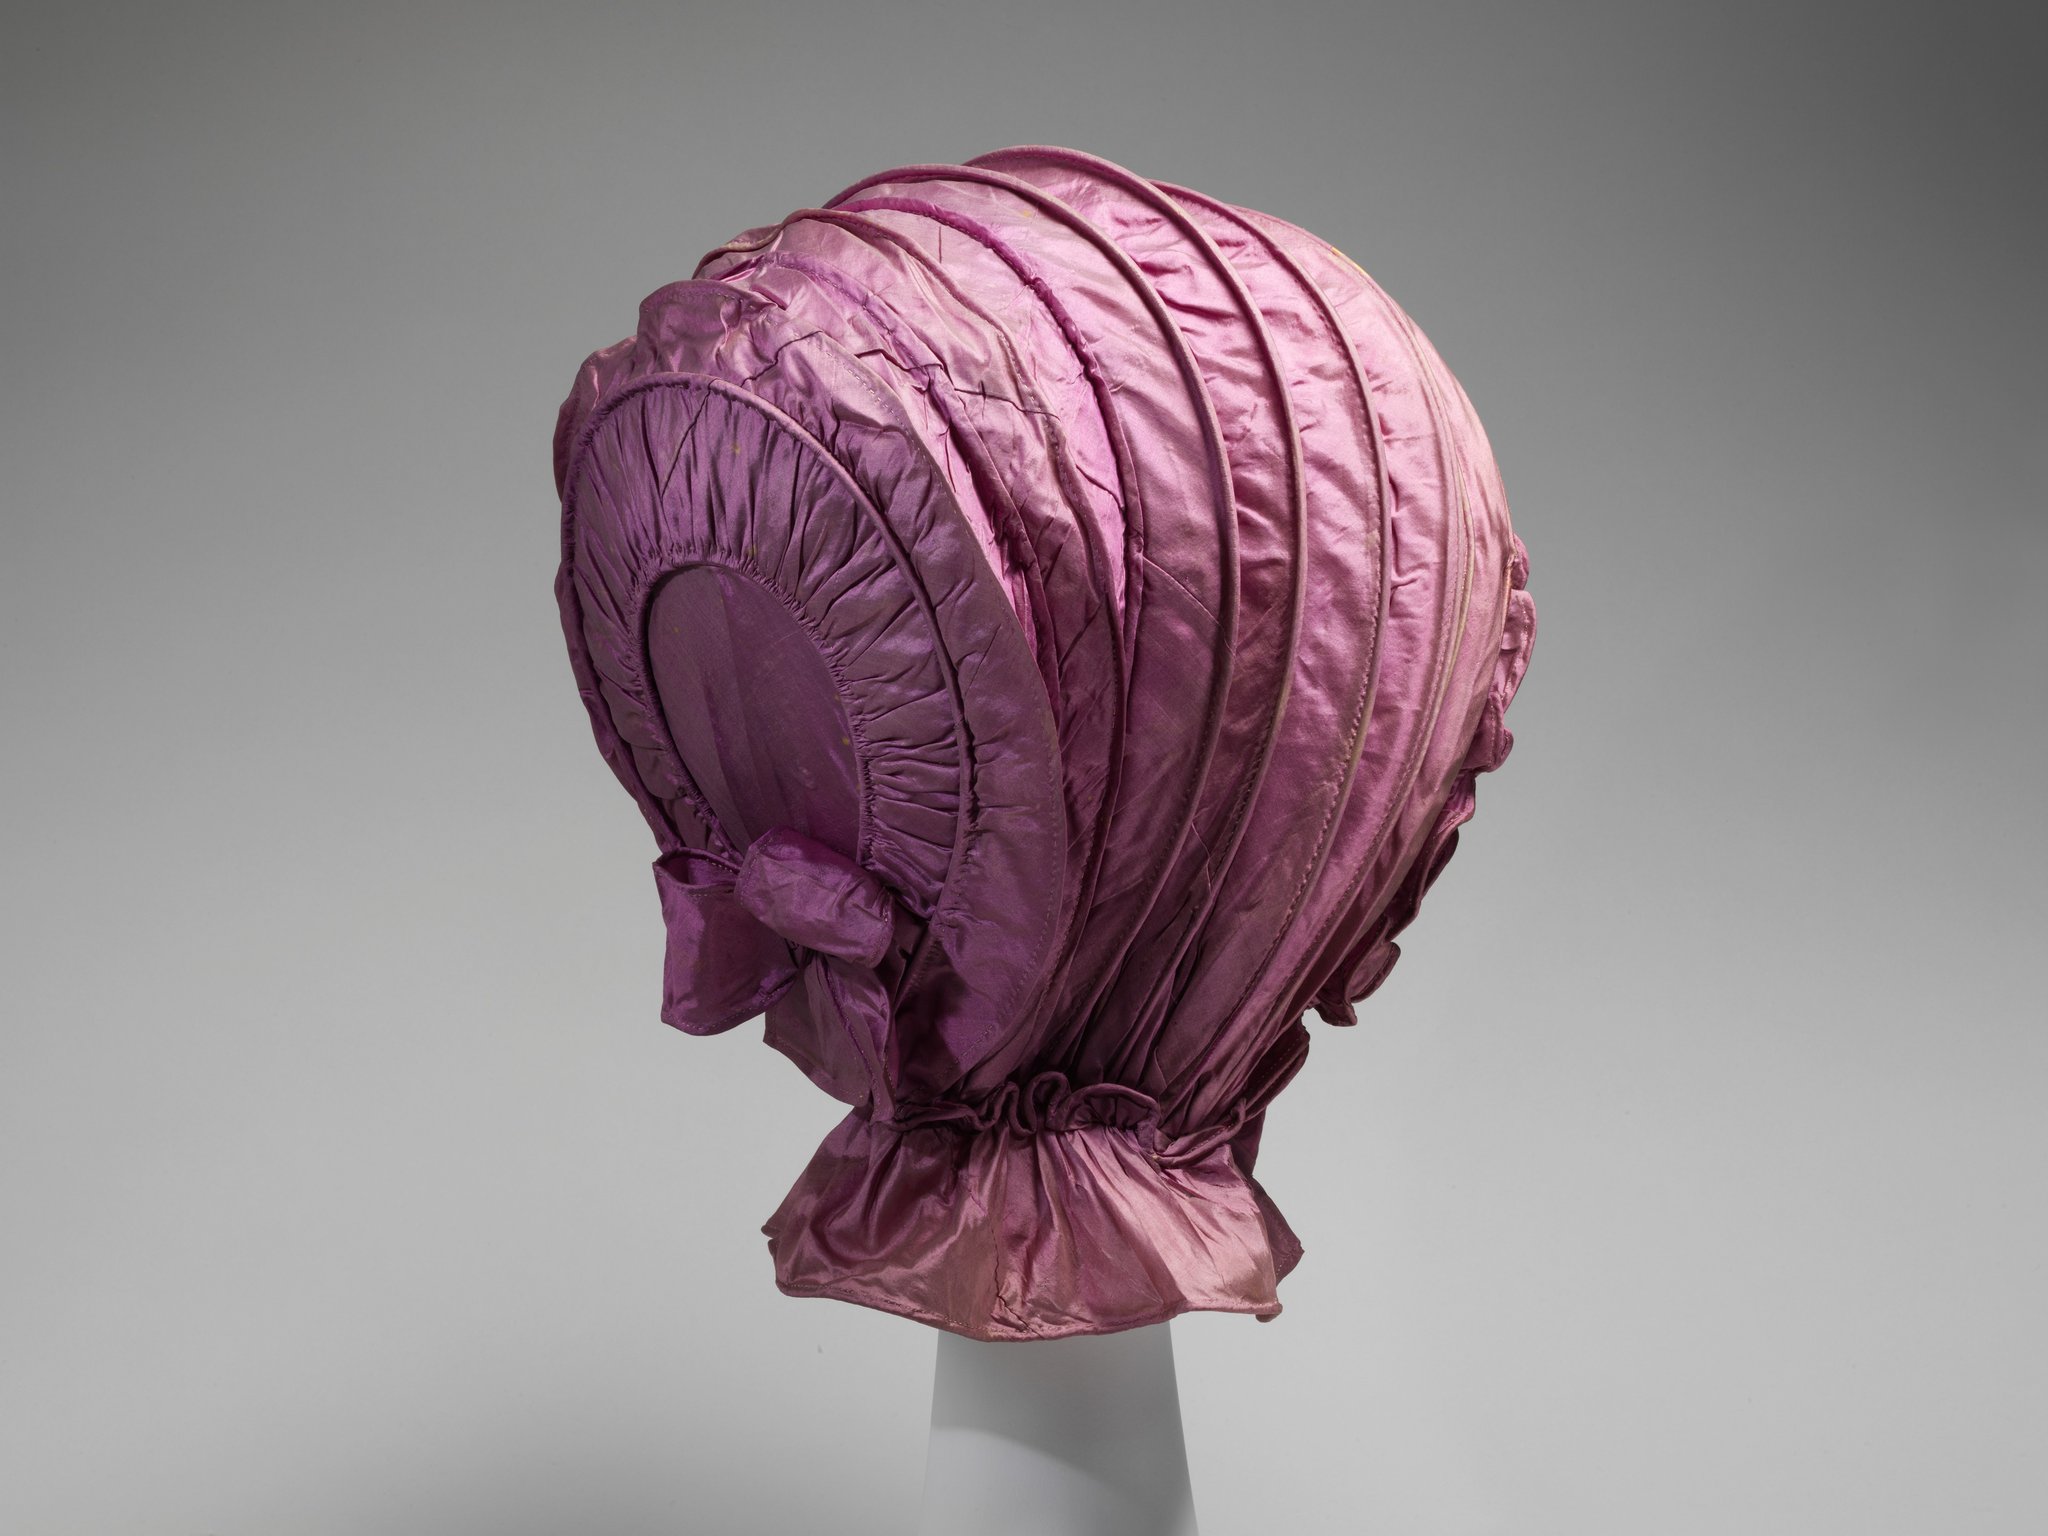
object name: calash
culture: american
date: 1701-1800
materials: silk